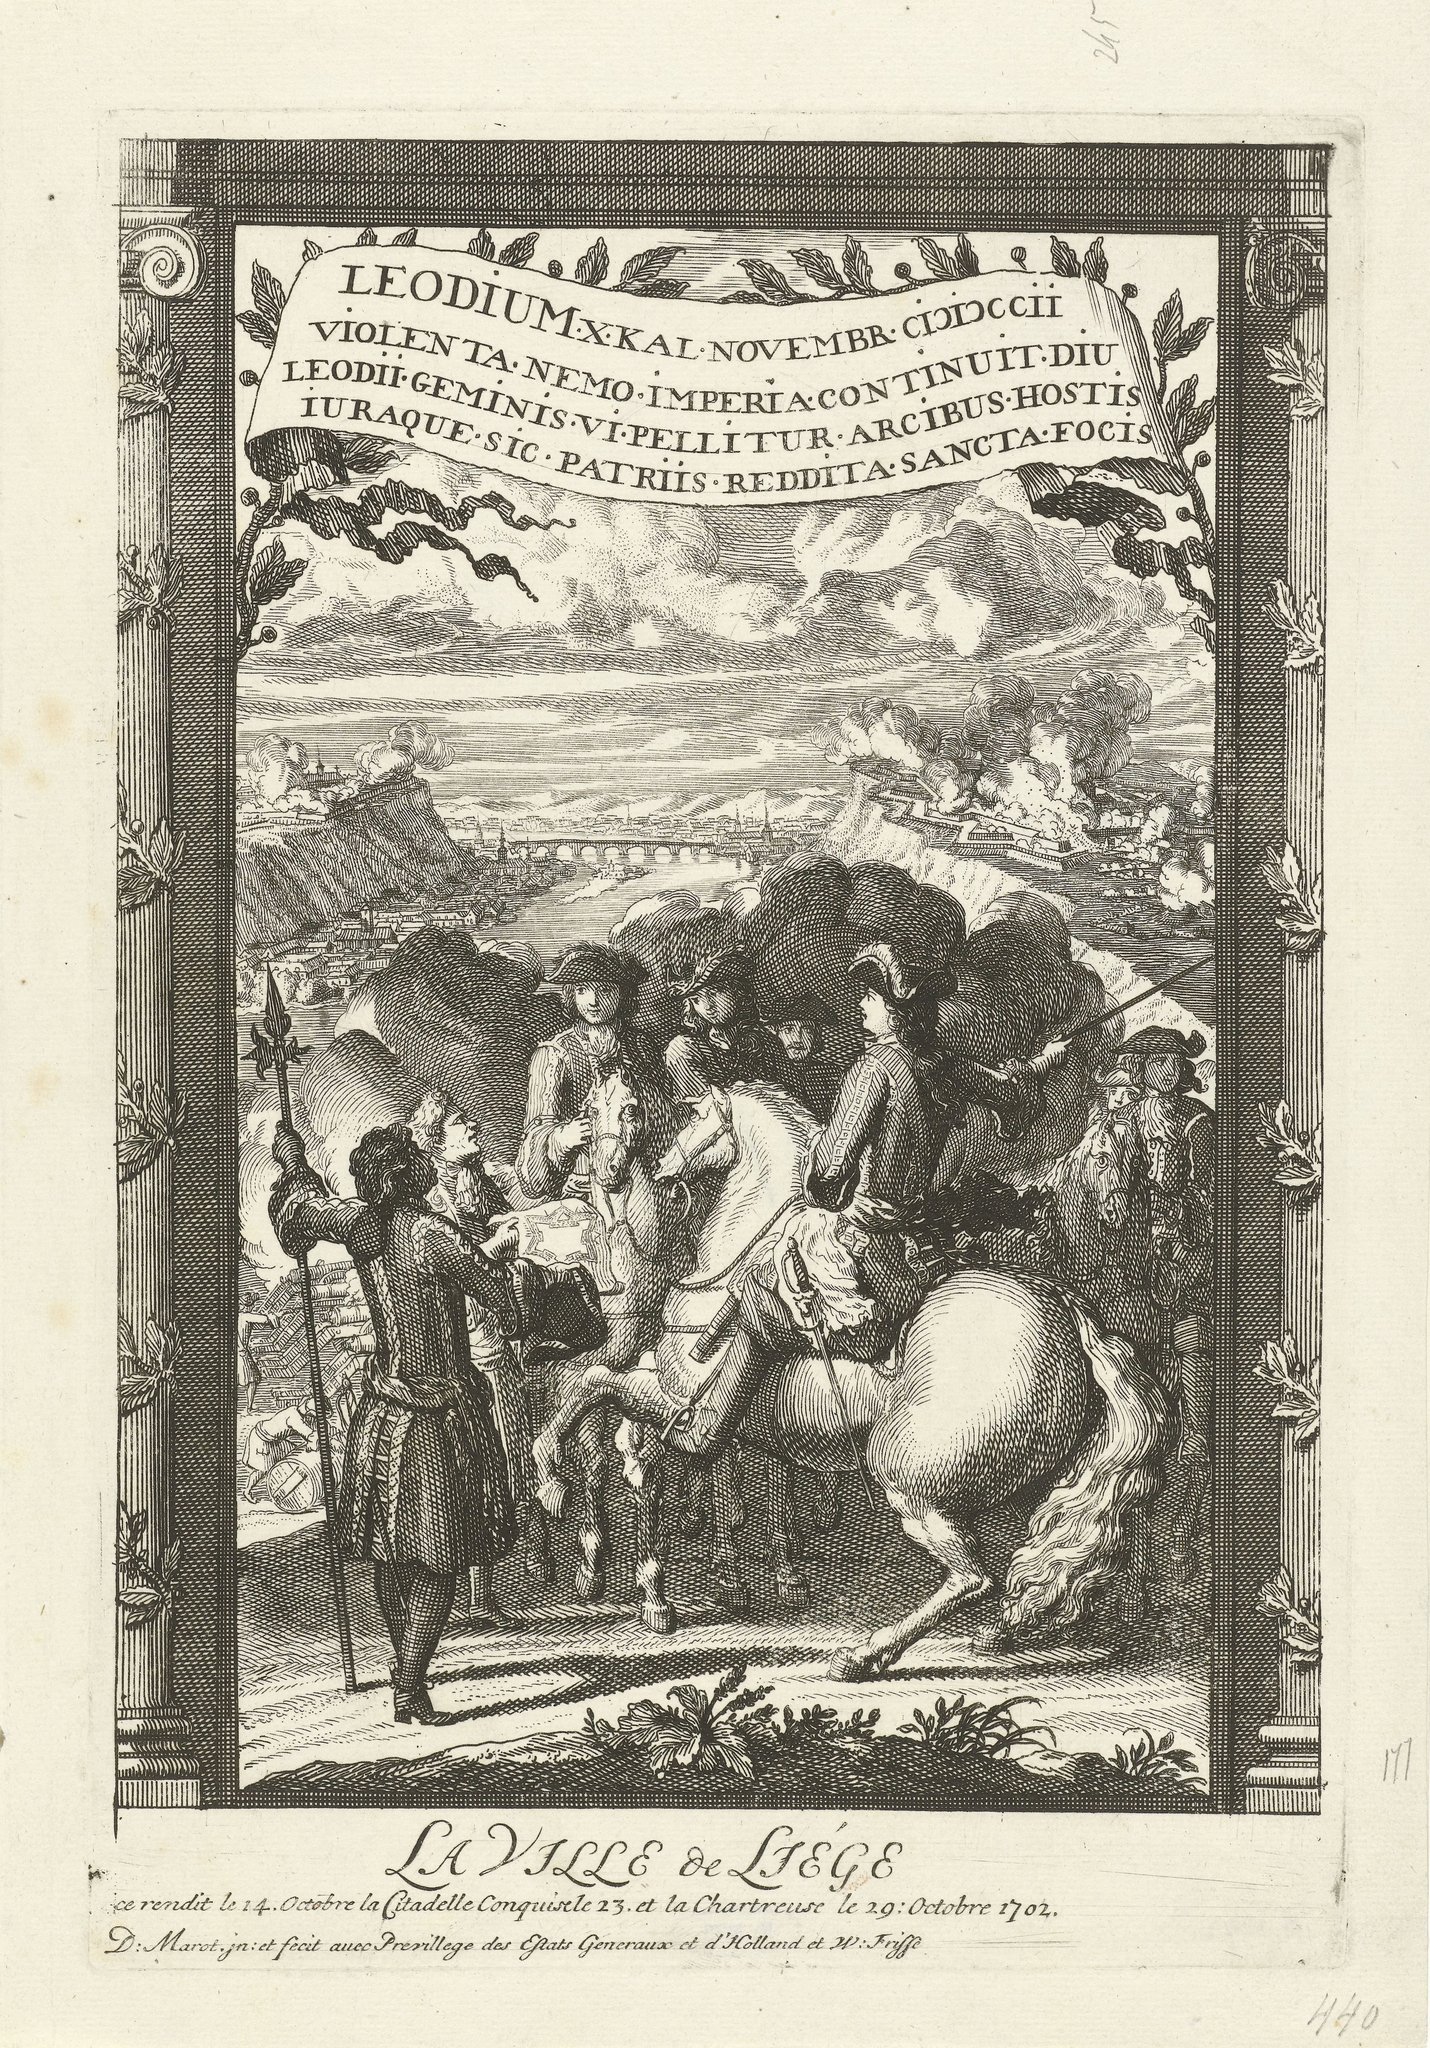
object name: print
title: Belegering van Luik, 1702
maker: daniël marot (i)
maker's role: draughtsman, print maker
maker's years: 1661-1752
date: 1702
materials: paper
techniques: etching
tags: capture of city (after the siege), liège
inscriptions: collector's mark: Lugt 2228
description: Paneel met een voorstelling van de overwinning te Luik op 23 en 29 oktober 1702. Onderdeel van de decoraties op de stellage met de Tempel van Mars tijdens het vuurwerk op de Hofvijver op 13 december 1702 te Den Haag. De Tempel van Mars was versierd met acht panelen met voorstellingen van overwinningen van de geallieerden op Frankrijk en Spanje in het jaar 1702.